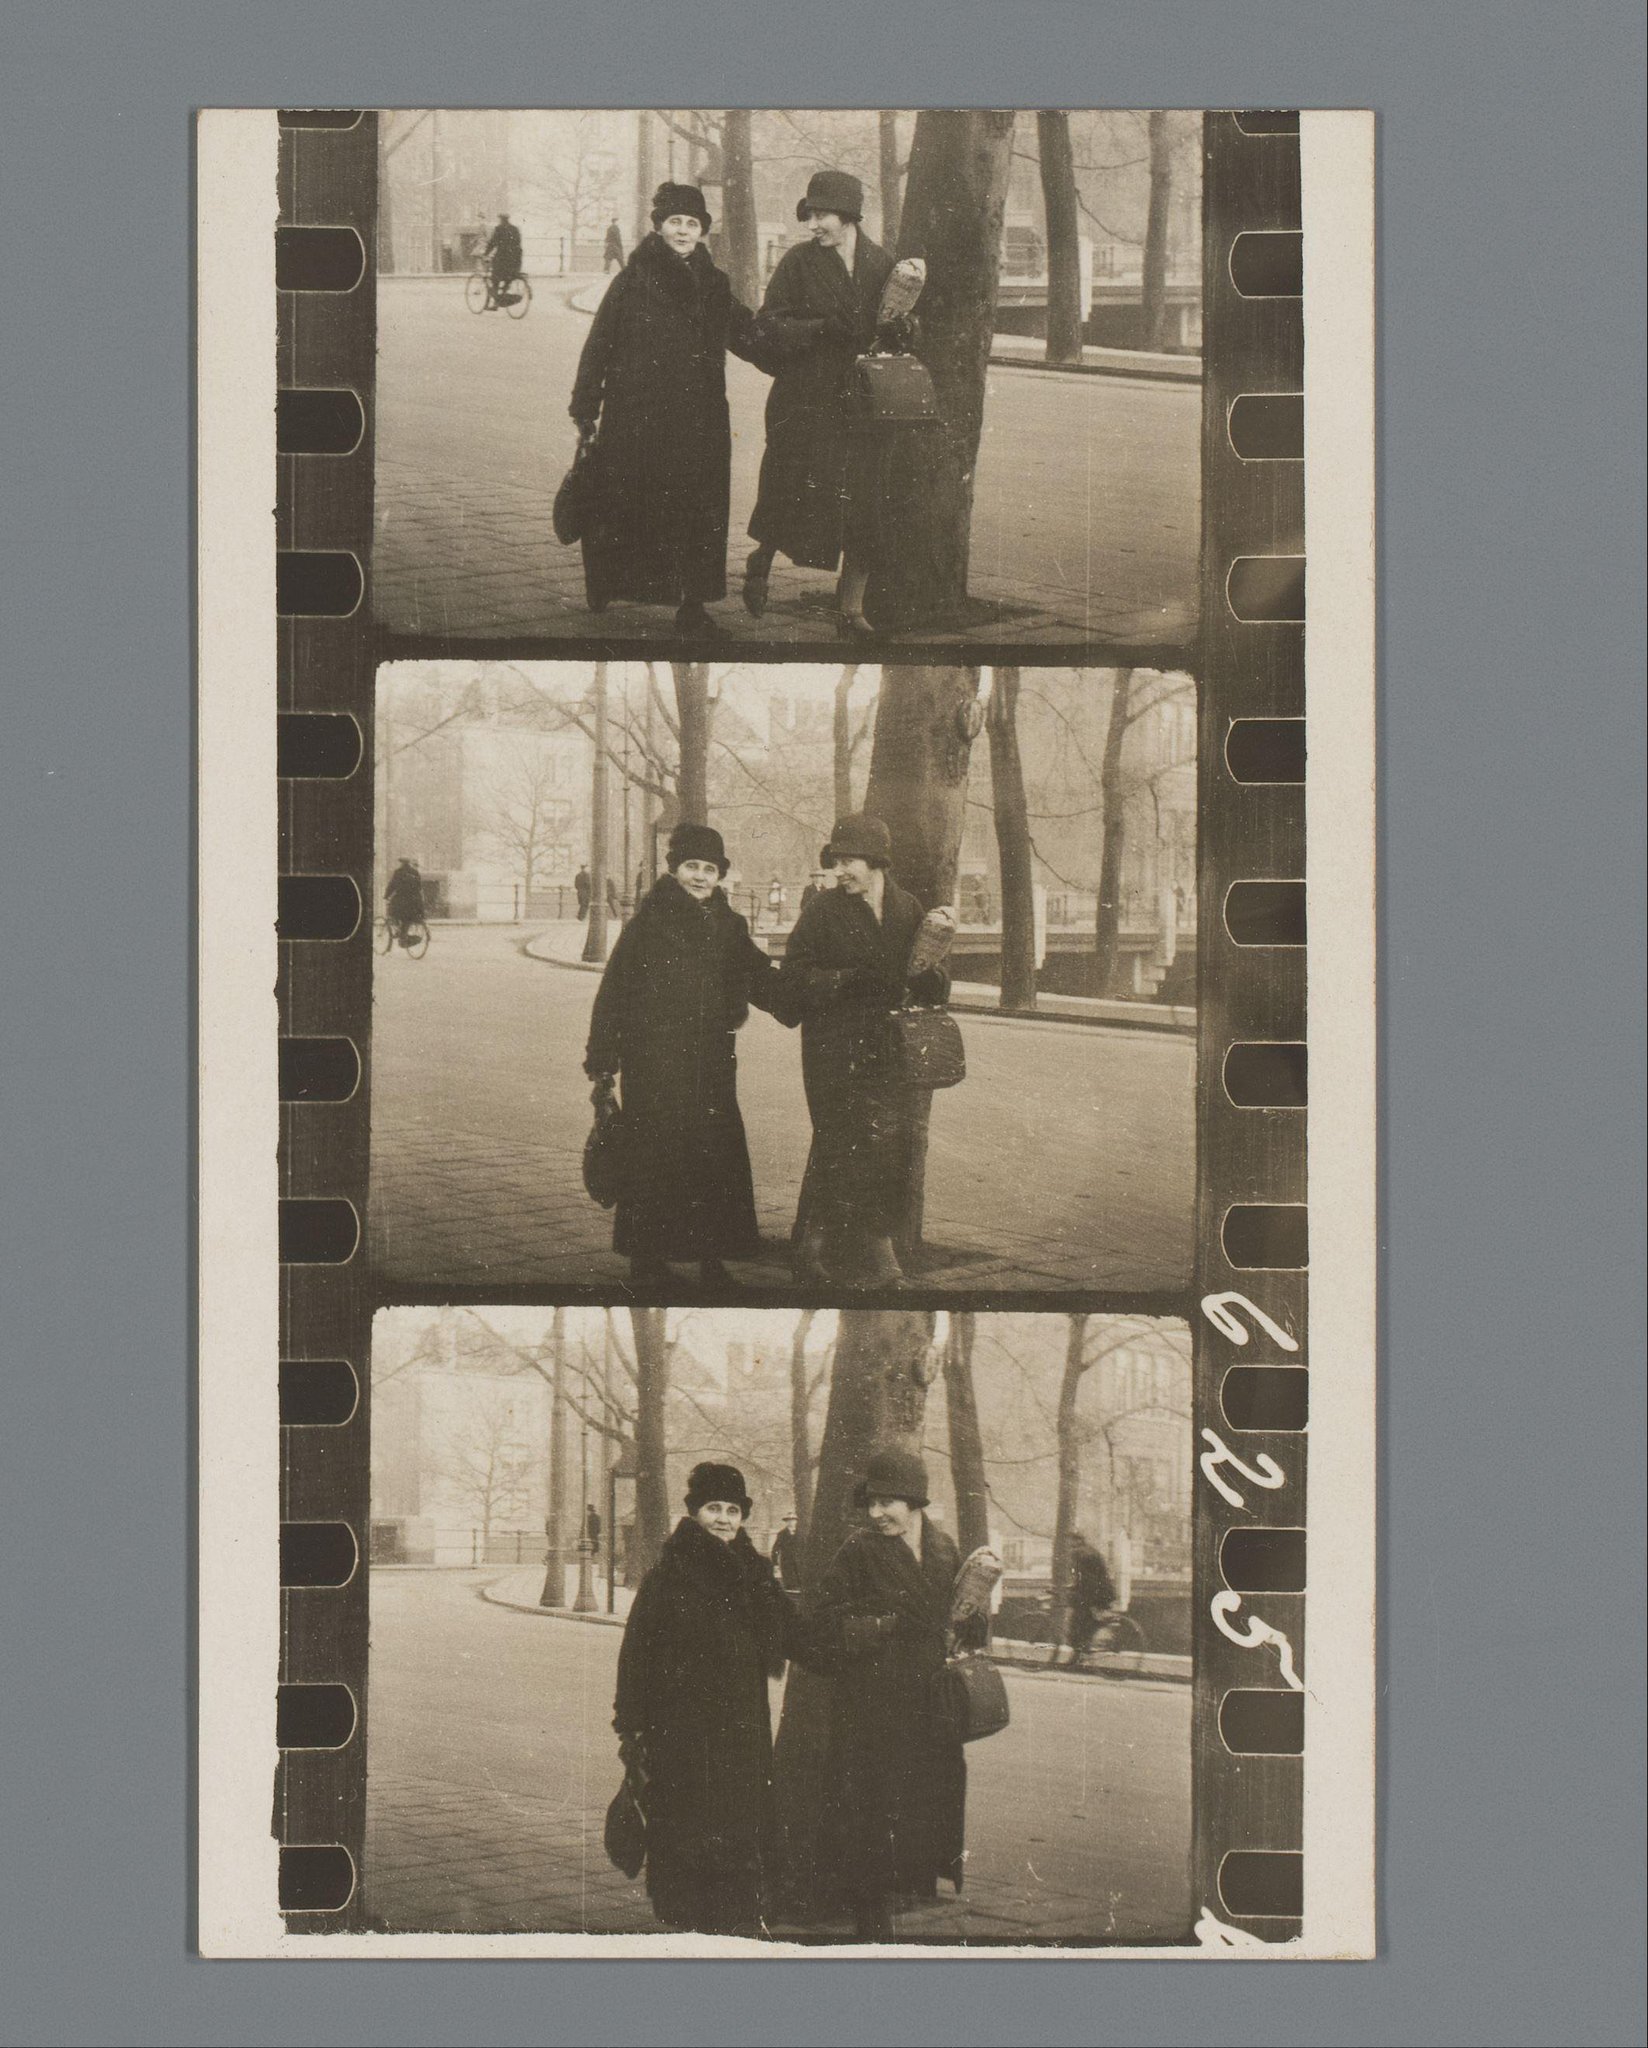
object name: ansichtkaart, prentbriefkaart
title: Prentbriefkaart met drie filmbeelden van twee onbekende vrouwen op straat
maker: Anonymous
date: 1910-1940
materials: paper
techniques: gelatin silver print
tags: adult woman, street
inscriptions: number: ‘625’